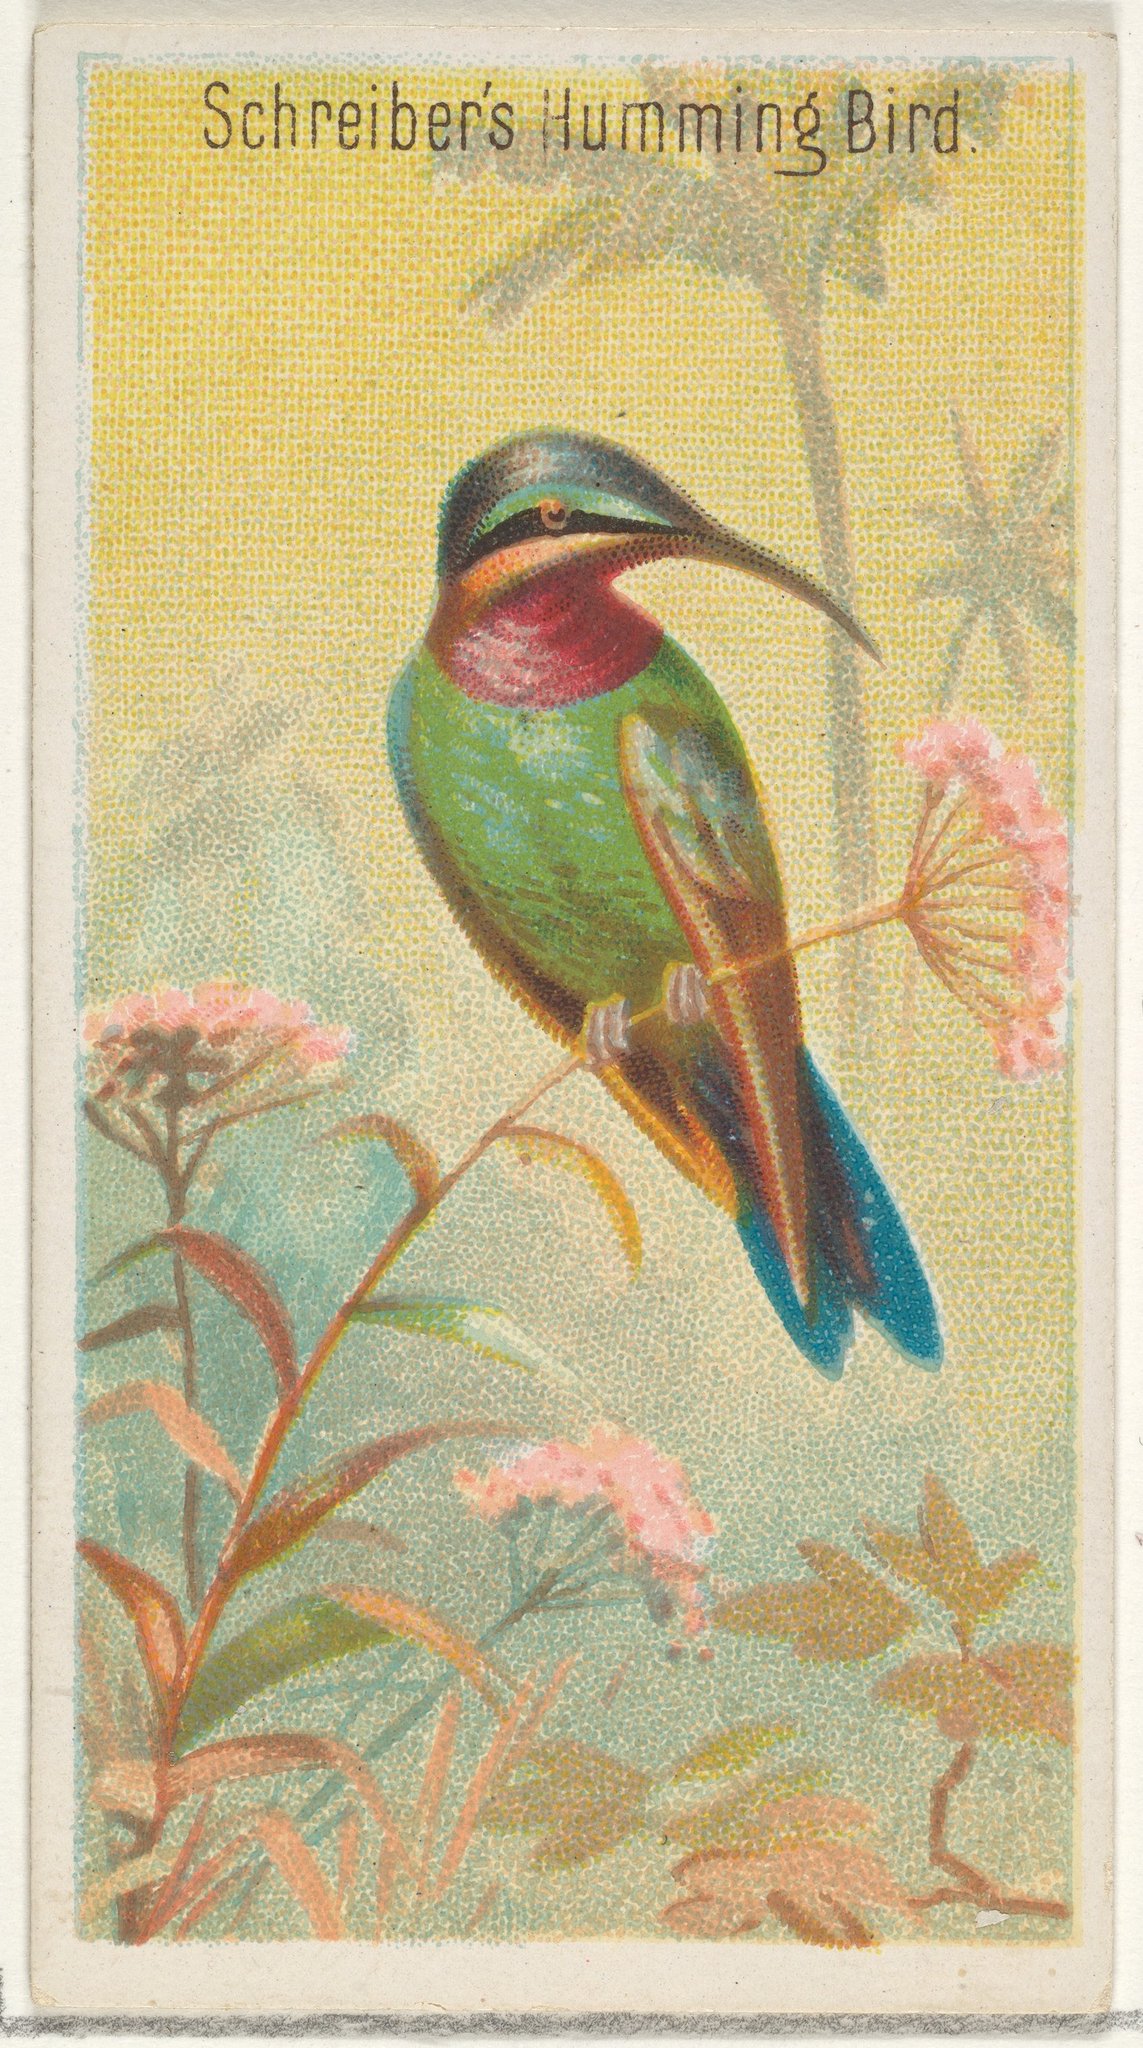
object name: print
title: Schreiber's Hummingbird, from the Birds of the Tropics series (N5) for Allen & Ginter Cigarettes Brands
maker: allen & ginter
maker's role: publisher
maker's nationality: american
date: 1889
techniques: color lithograph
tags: birds